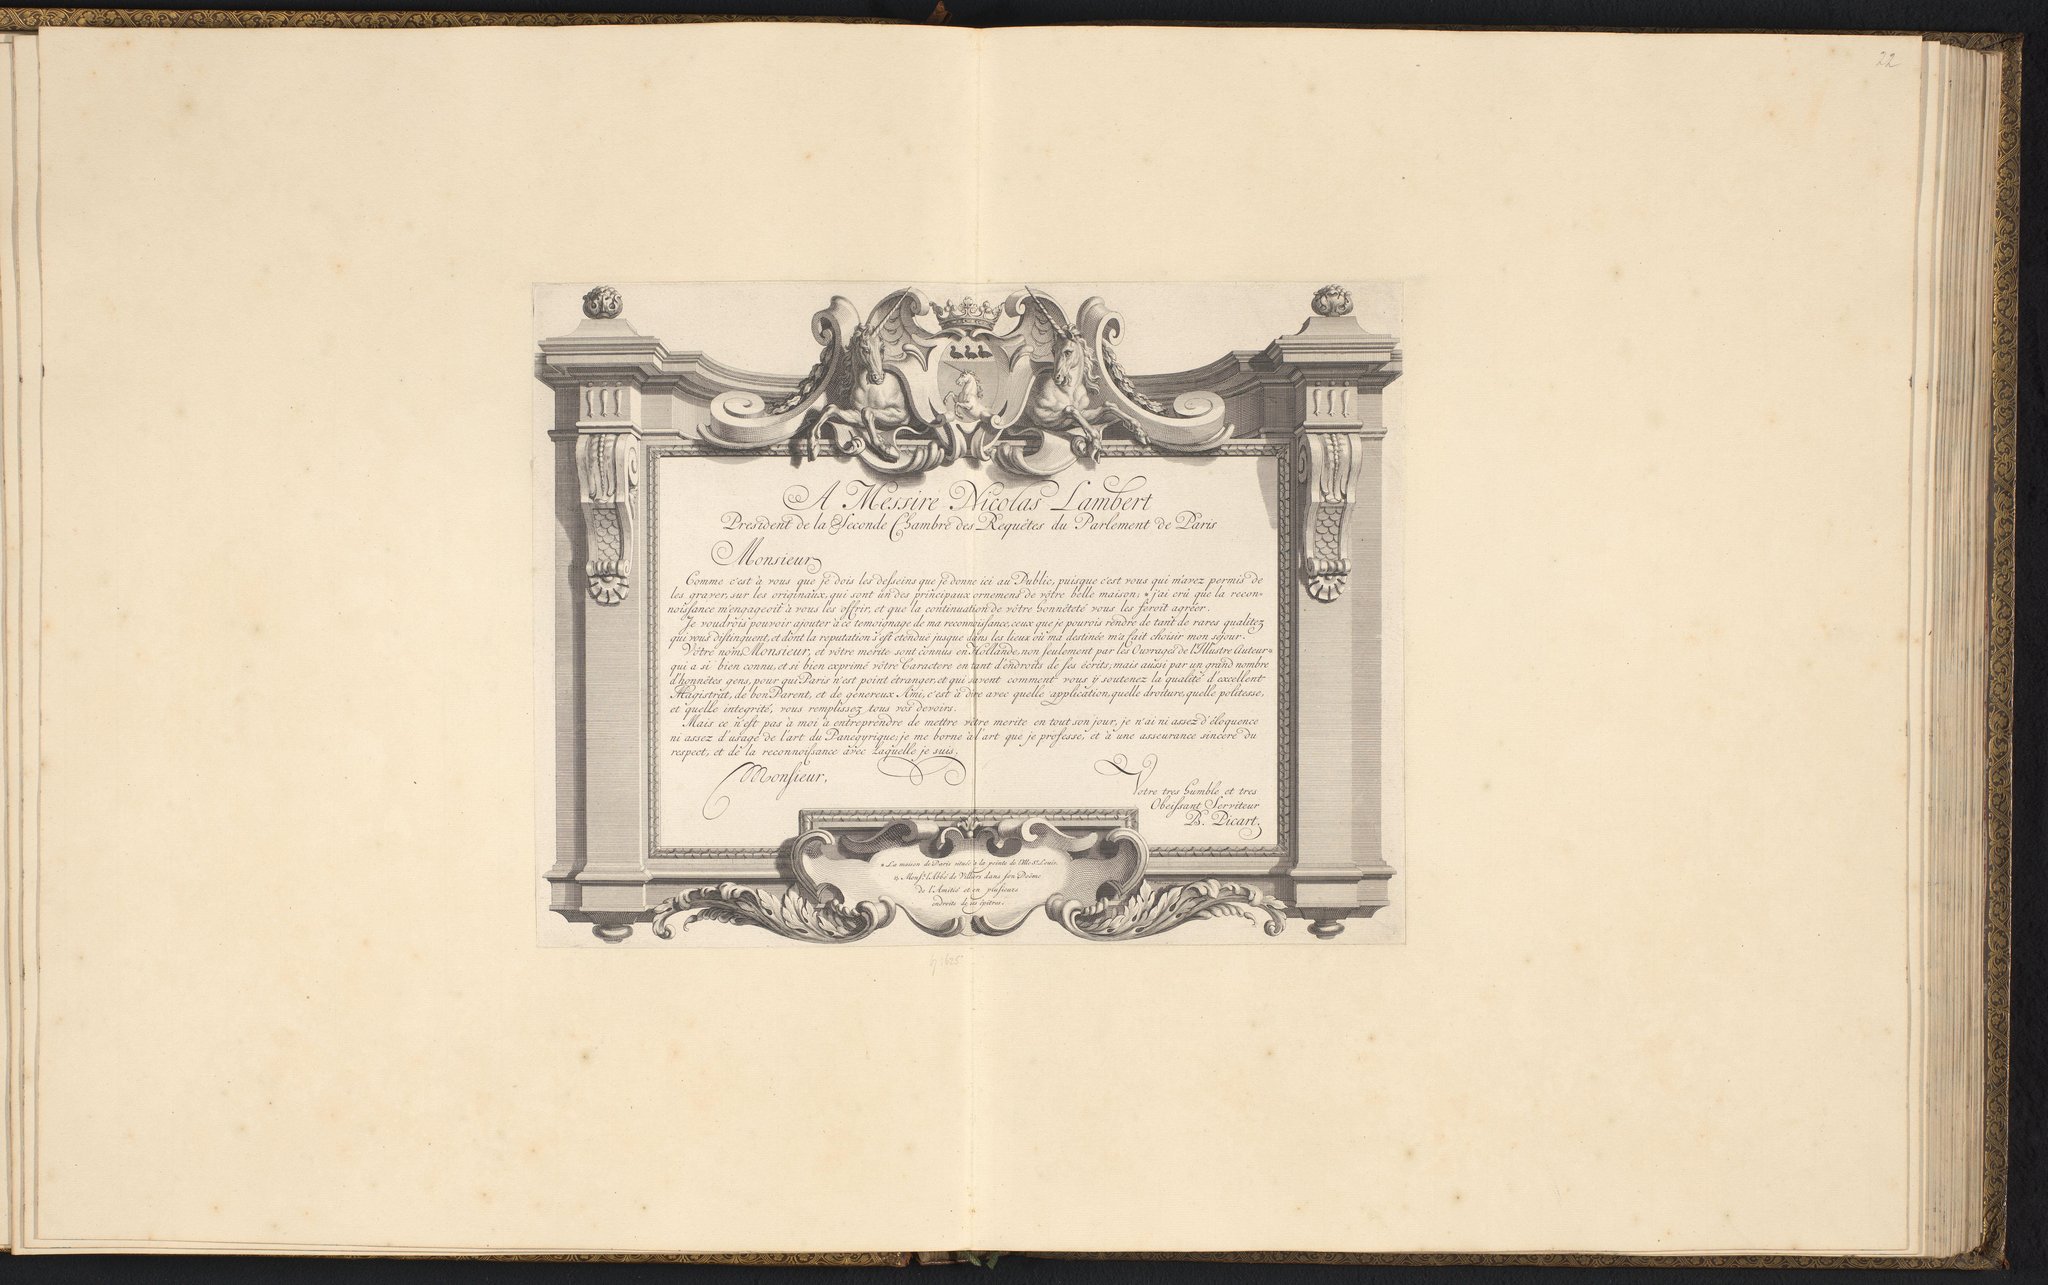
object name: album leaf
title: La galerie de monsr. le president Lambert representant l'Apotheose d'Hercule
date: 1683-1733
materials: paper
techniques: engraving, etching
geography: amsterdam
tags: nicolas lambert de thorigny (iii), coat of arms (as symbol of the state, etc.), unicorn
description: Opgedragen aan Nicolas Lambert de Thorigny. Gegraveerde tekst in een architectonisch kader met een eenhoorn aan weerszijden van een wapenschild. Deze prent maakt deel uit van een album.